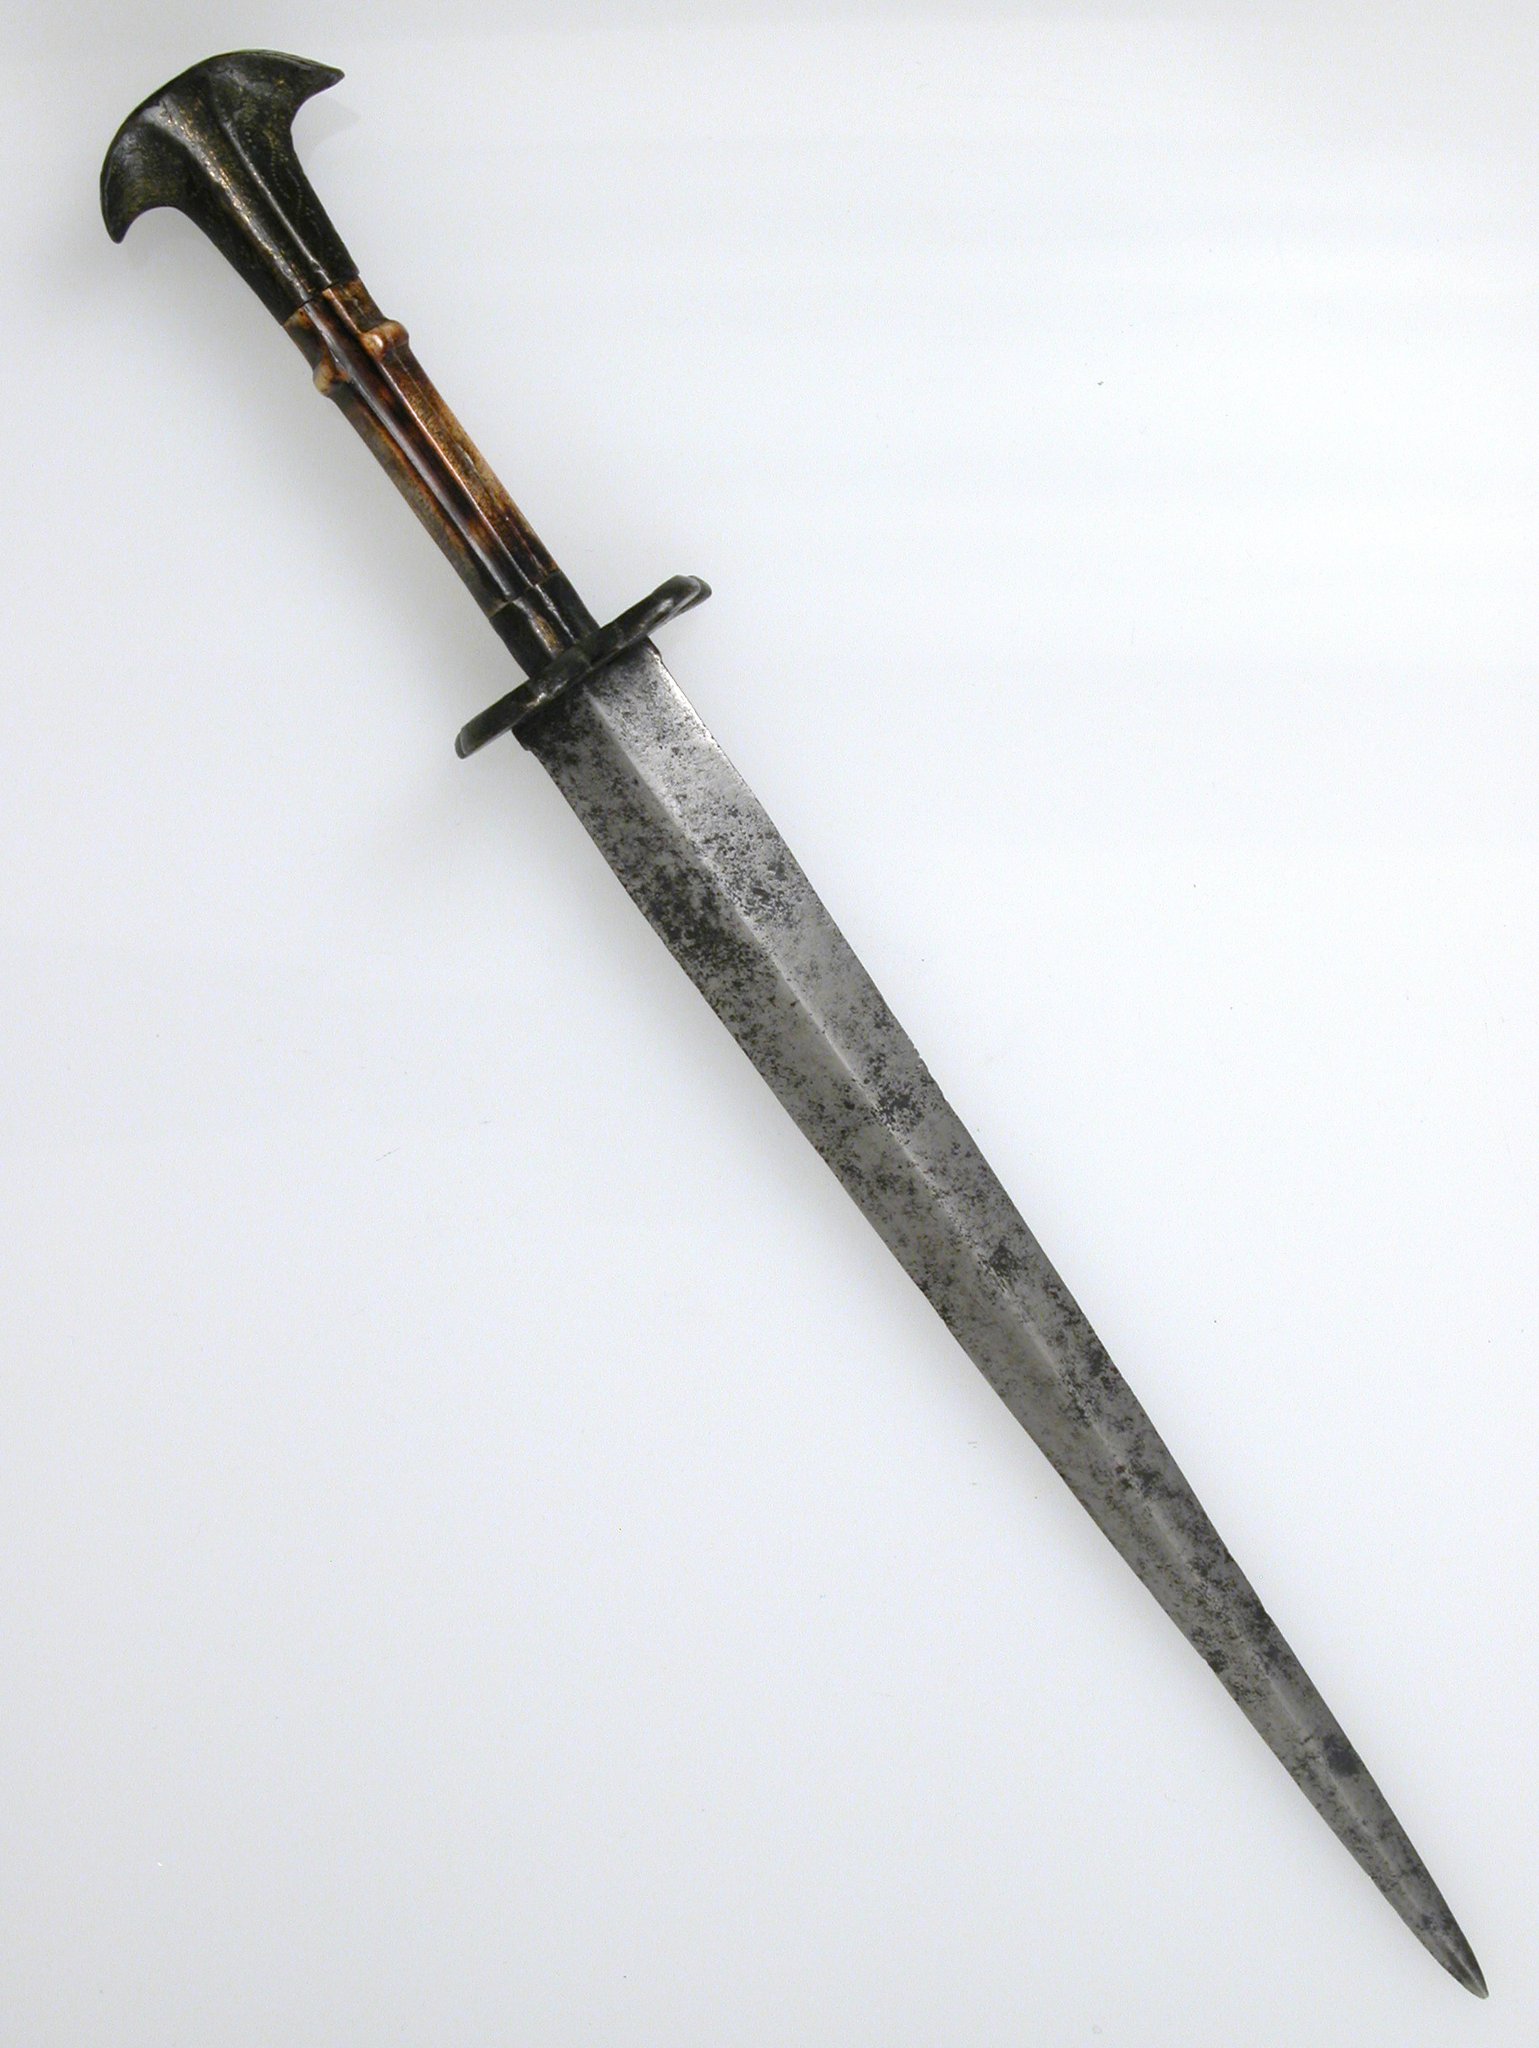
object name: dagger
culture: french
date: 1467-1500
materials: bone, bronze, steel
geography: france